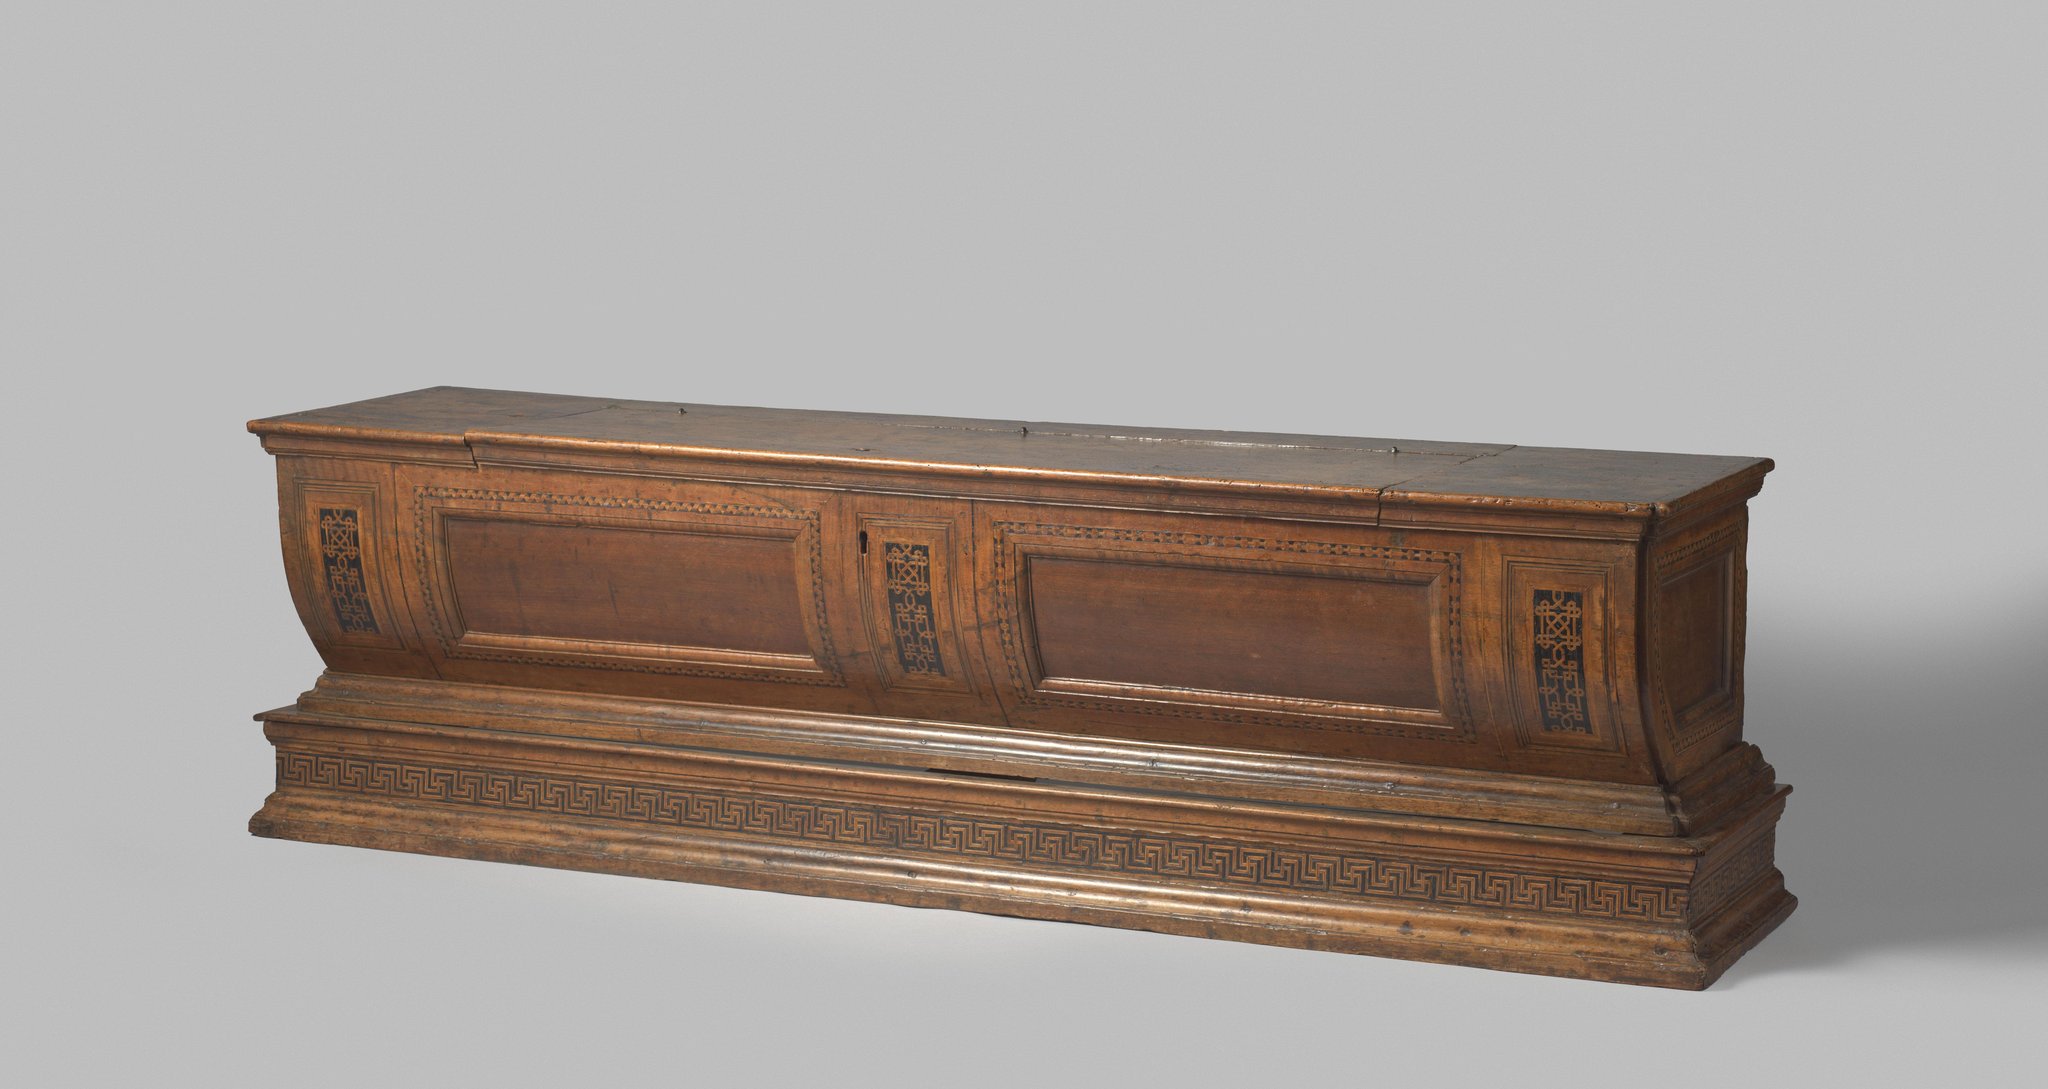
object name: seating furniture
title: Bank van notenhout met binnenwerk van populierenhout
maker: Anonymous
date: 1500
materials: wood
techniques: intarsia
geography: florence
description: Bank van notenhout met binnenwerk van populierenhout en versierd met intarsia. In het voetstuk een fries met meanderrand in intarsia. De voorzijde is licht bolvormig gebogen en vertoont op de hoeken en in het midden een licht vooruitspringend veld, waartussen twee gladde panelen; dit alles binnen profiellijsten en door intarsia-randen omgeven. Het middendeel vormt de kistdeksel. De zijwanden hebben gladde panelen. Zie tevens BK-16633 en BK-NM-12354.